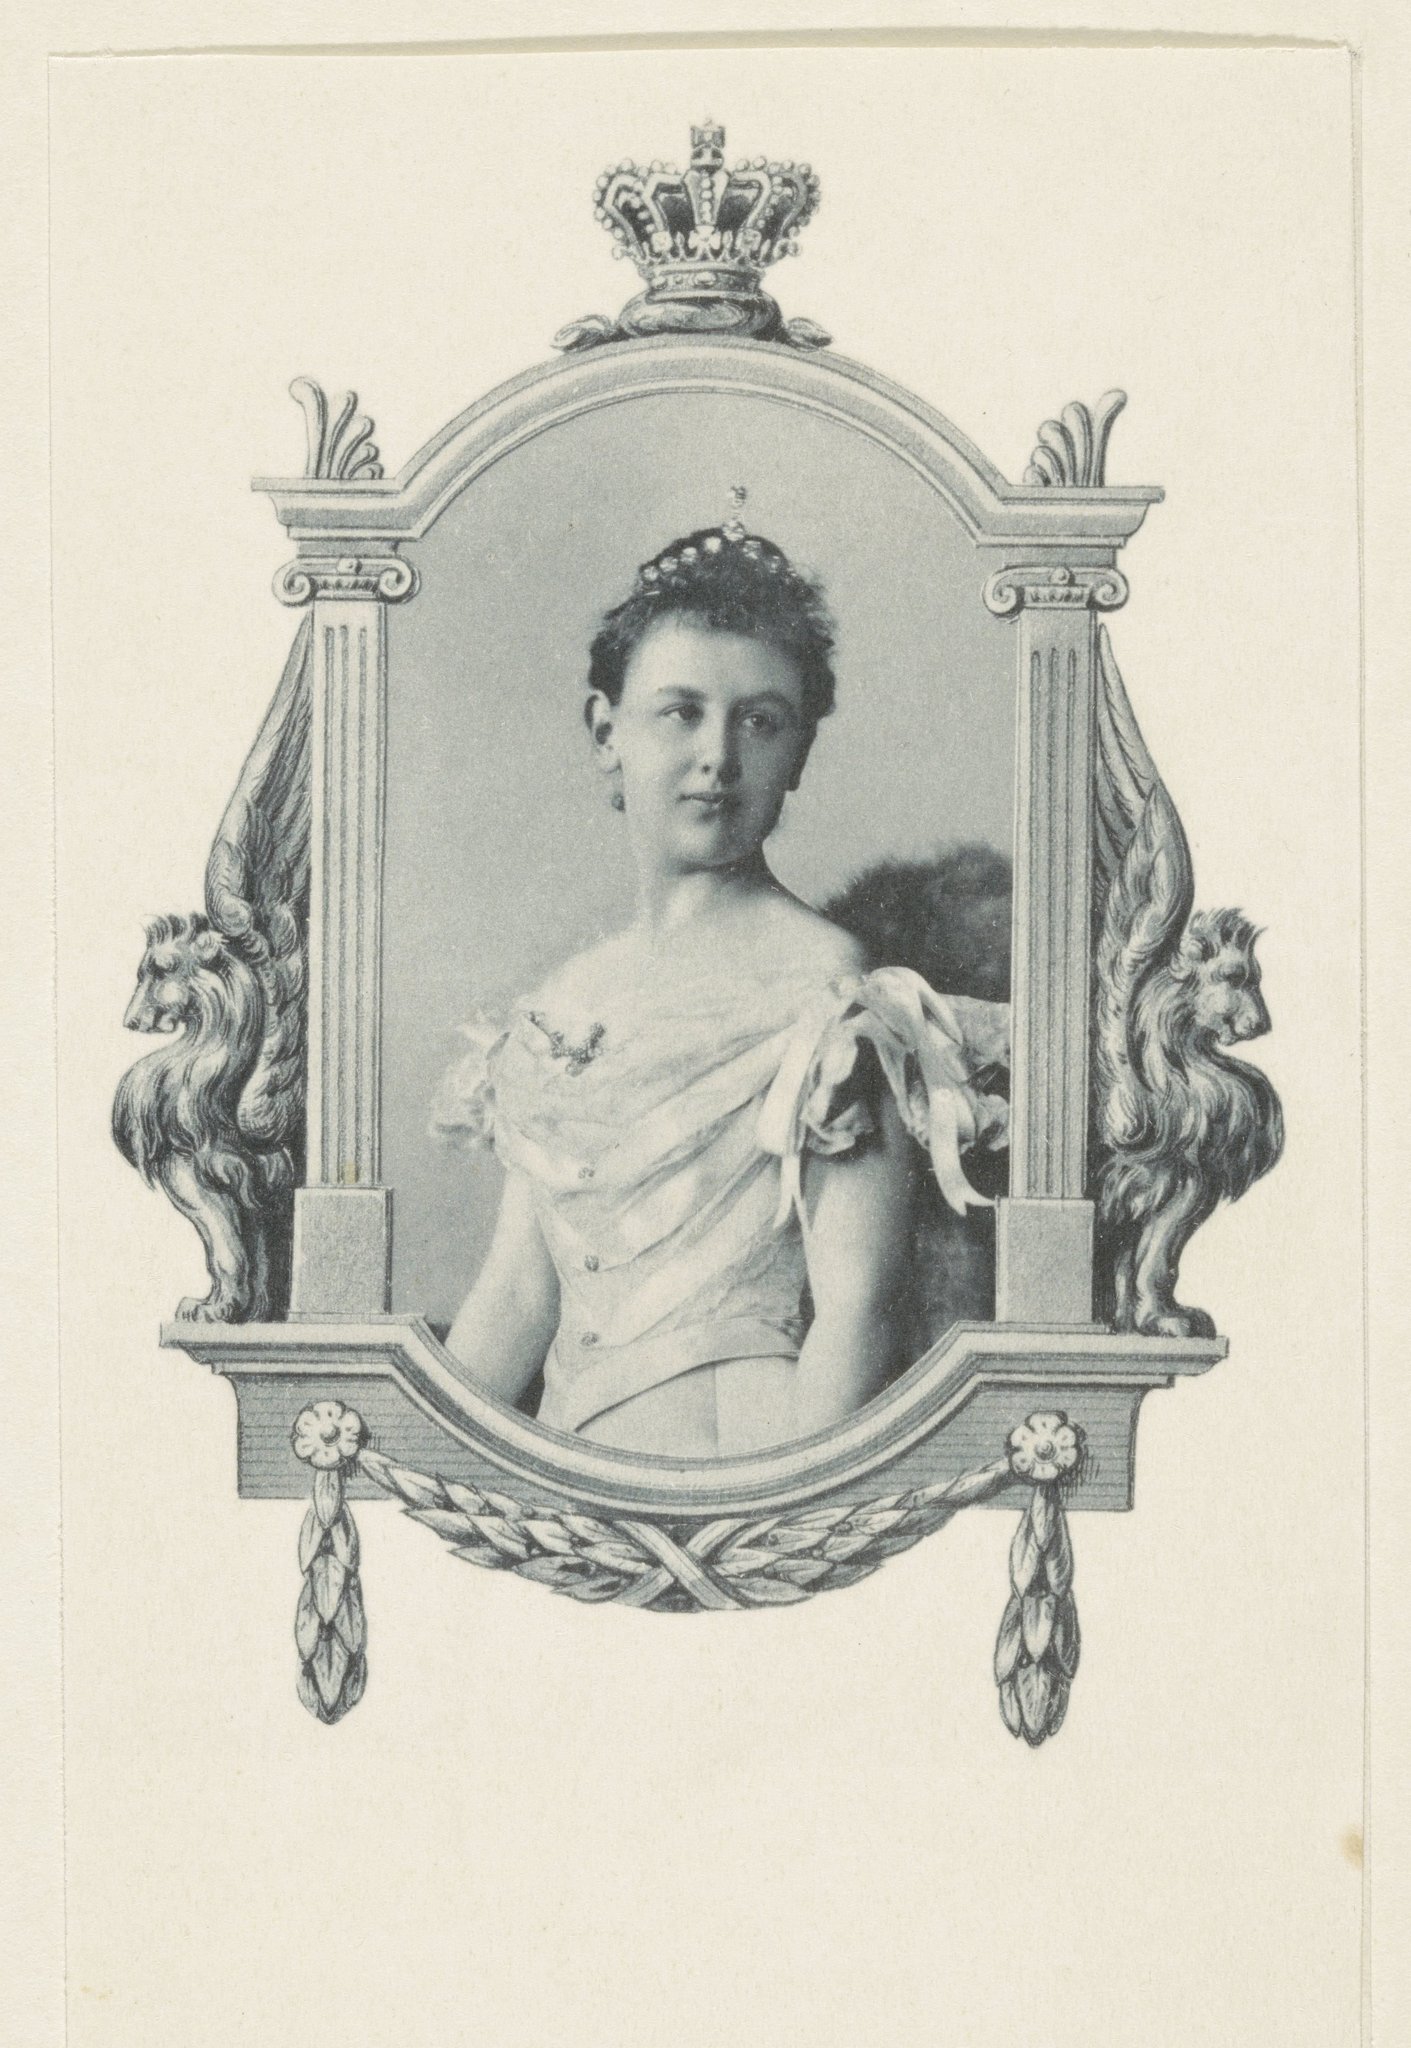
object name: photomechanical print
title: Portret van Wilhelmina, koningin der Nederlanden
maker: Anonymous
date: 1897-1899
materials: paper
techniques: photograph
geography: netherlands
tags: the hague, print maker, wilhelmina of the netherlands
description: De hier vermelde titel verwijst naar de hoogst verkregen titel van de geportretteerde, niet per se naar de titel die de geportretteerde op deze voorstelling draagt.